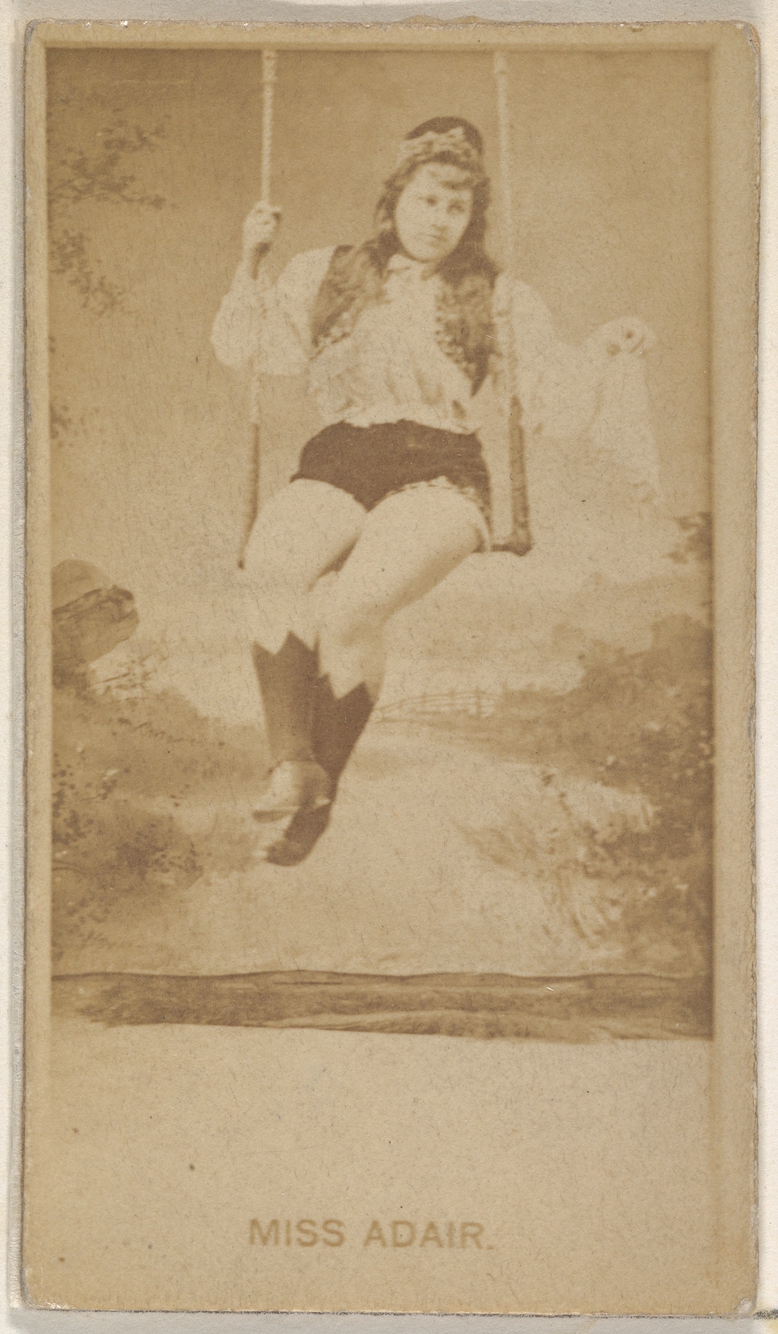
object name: photograph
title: Miss Adair, from the Actors and Actresses series (N45, Type 8) for Virginia Brights Cigarettes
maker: allen & ginter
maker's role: publisher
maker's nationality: american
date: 1888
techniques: albumen silver print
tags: portraits,women,actresses